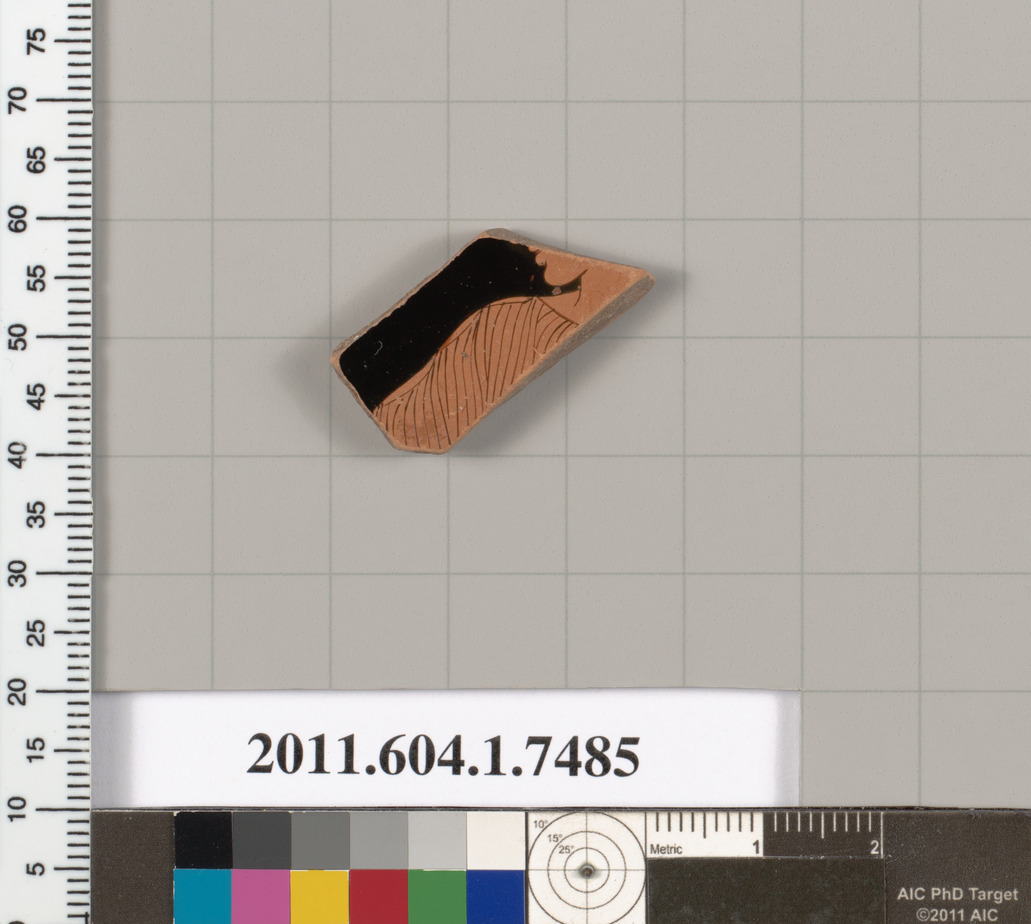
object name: kylix fragment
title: Terracotta fragment of a kylix (drinking cup)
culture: greek, attic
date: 460-450 BCE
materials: terracotta